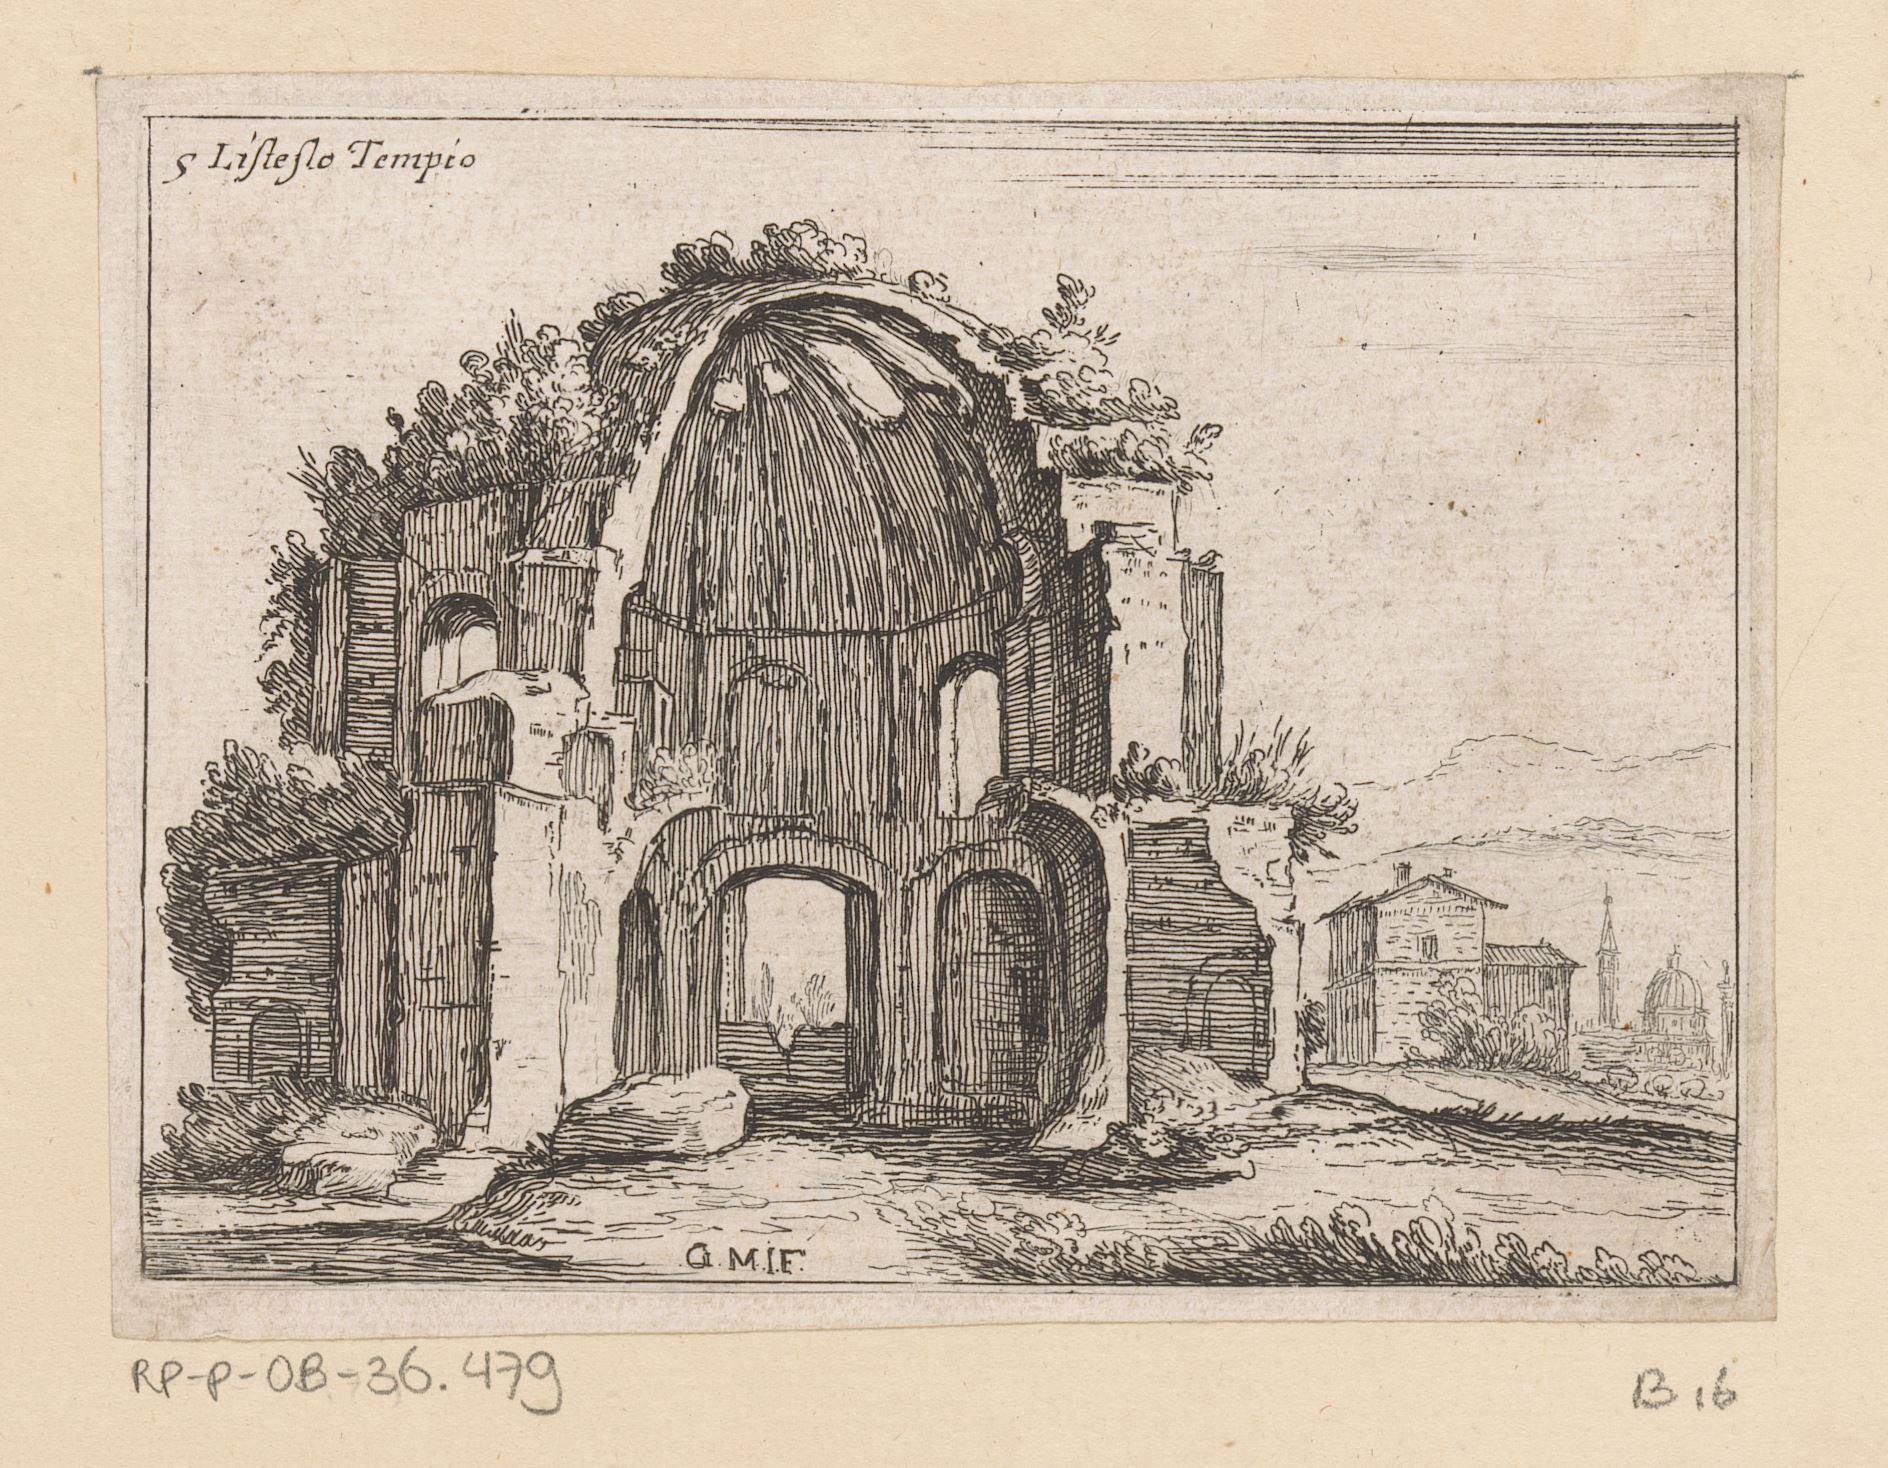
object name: print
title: Listesso Tempio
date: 1629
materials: paper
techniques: etching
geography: tuscany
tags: (story of) minerva (pallas, athena), landscape with ruins, temple, shrine ~ roman religion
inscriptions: collector's mark: Lugt 2228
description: Deze prent maakt deel uit van een reeks van 52 prenten.